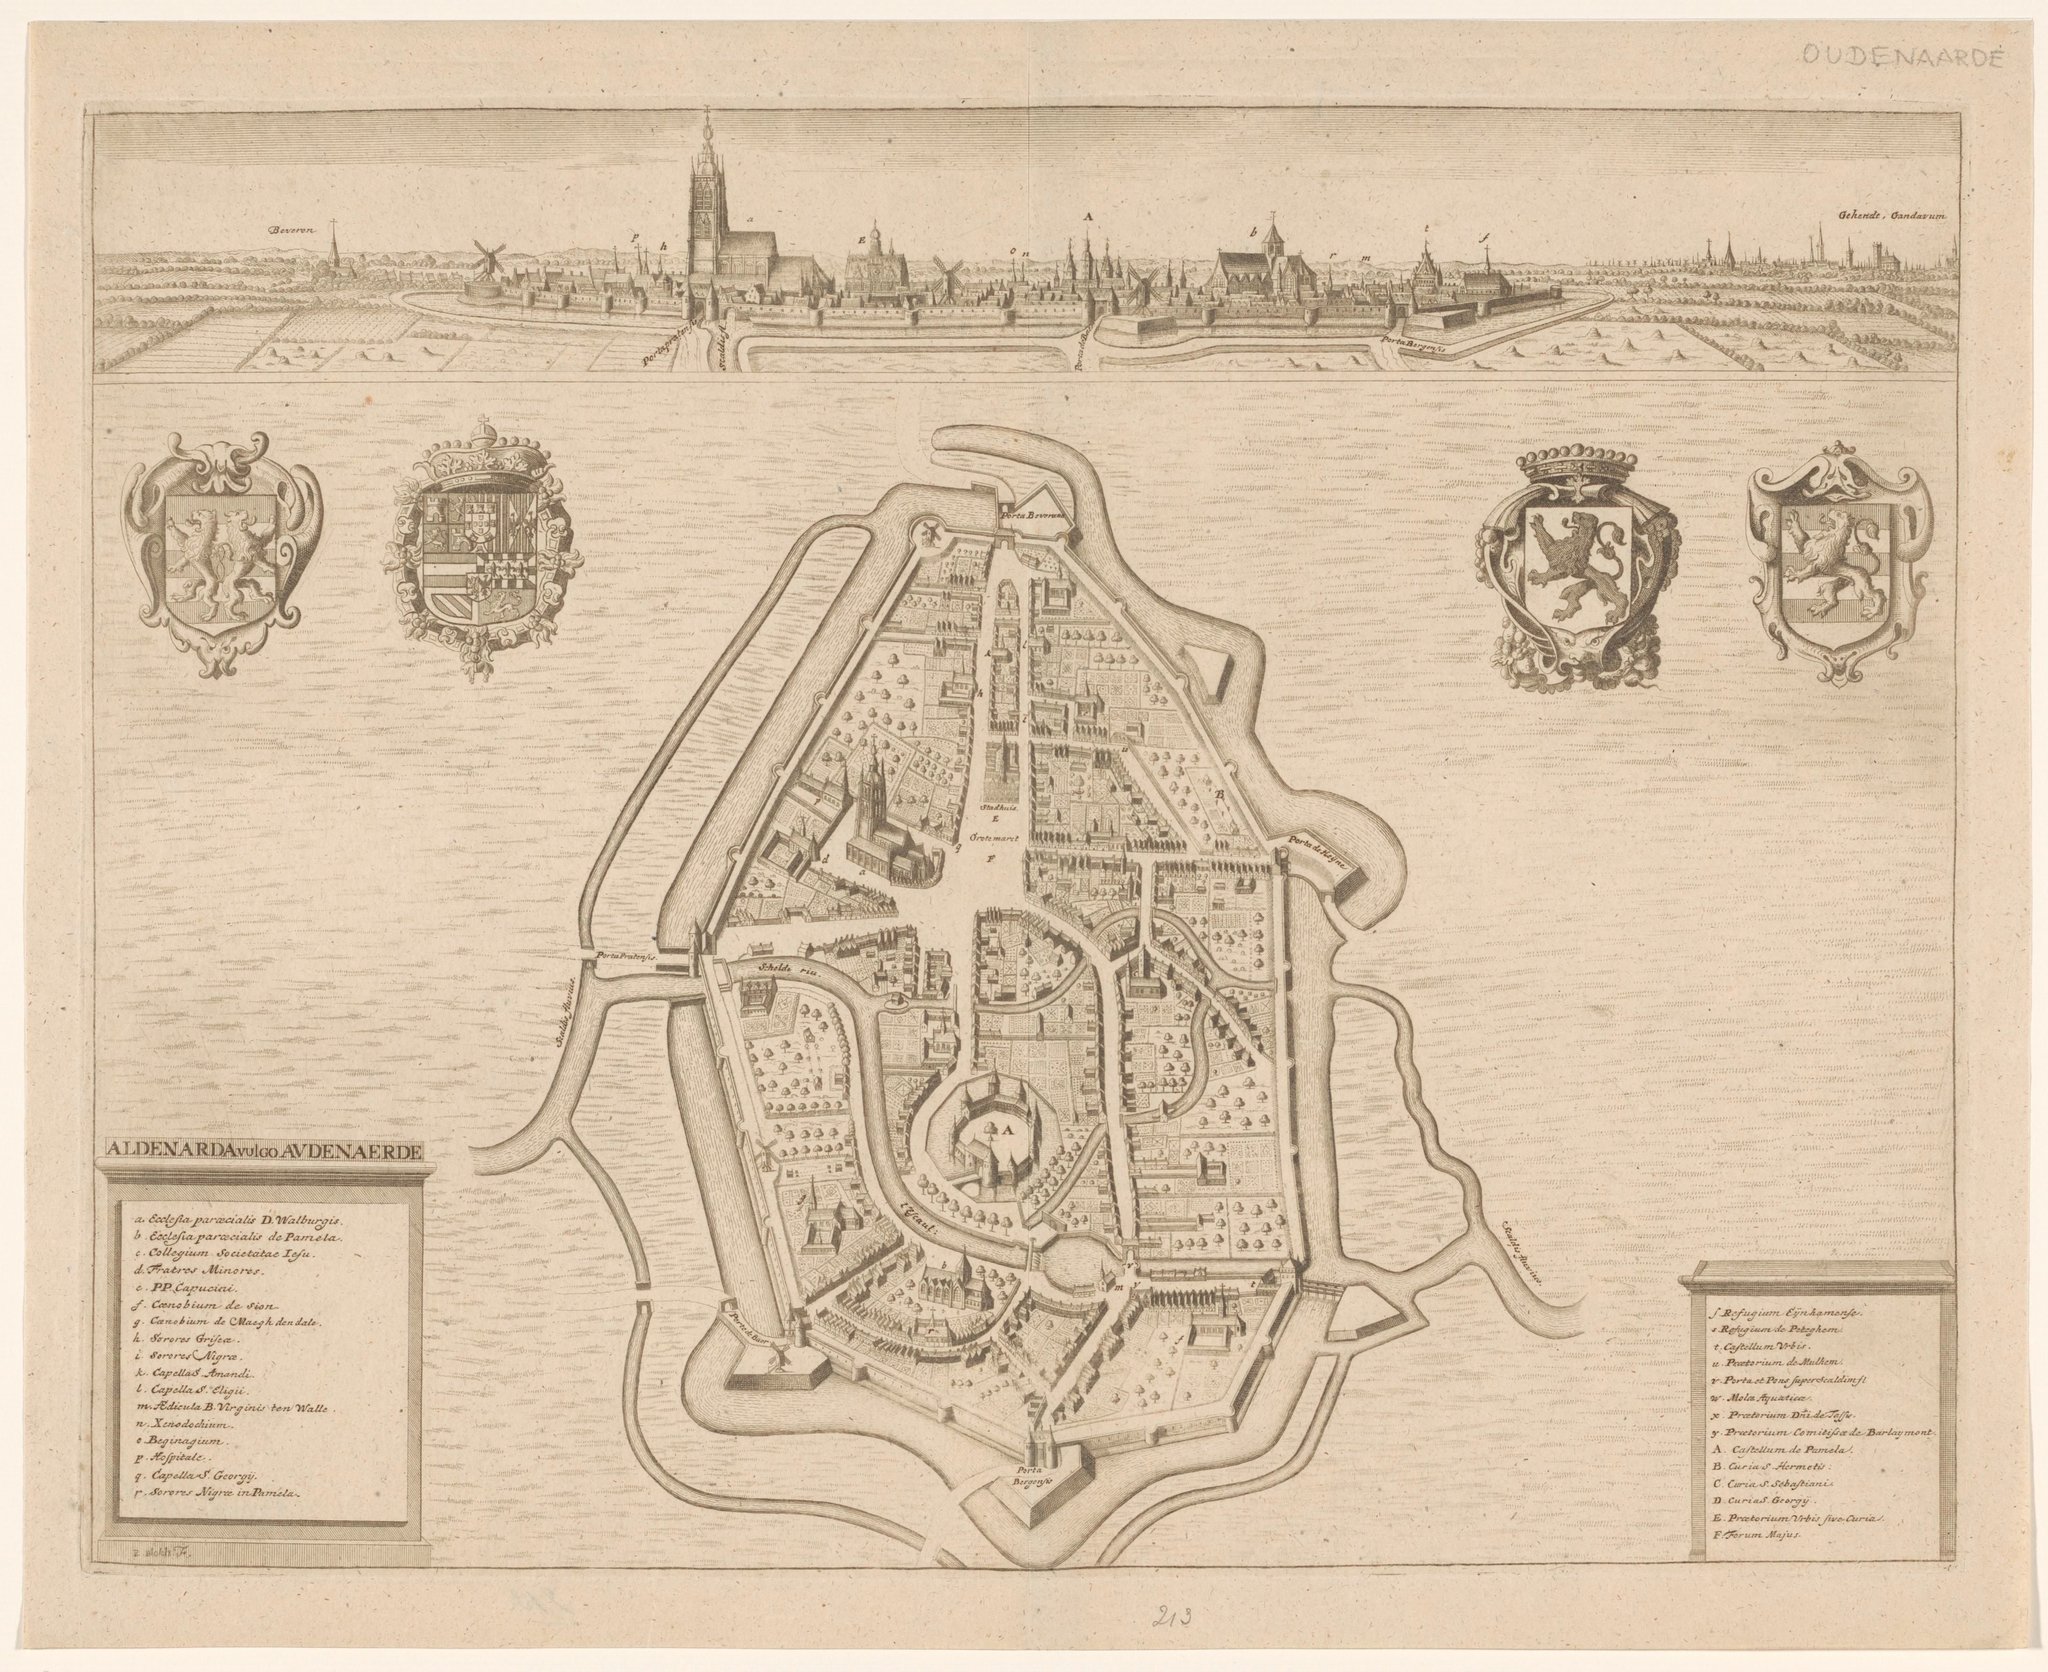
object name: print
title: Aldenarda vulgo Audenaerde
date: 1735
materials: paper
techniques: engraving, etching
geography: leiden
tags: coat of arms (as symbol of the state, etc.) (+ city; municipal), maps of cities, coat of arms (as symbol of the state, etc.) (+ province; provincial), prospect of city, town panorama, silhouette of city, armorial bearing, heraldry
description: Boven een gezicht op Oudenaarde. Onder een plattegrond van Oudenaarde met gebouwen in vogelvluchtperspectief. Linksboven het wapen van Oudenaarde, met twee gespiegelde leeuwen, rechts daarvan het wapen van de koning van Spanje. Rechtsboven het wapen van Oudenaarde met links daarvan het wapen van Vlaanderen. Linksonder een cartouche met legenda a-r. Rechtsonder het vervolg van de legenda s-y en A-F.